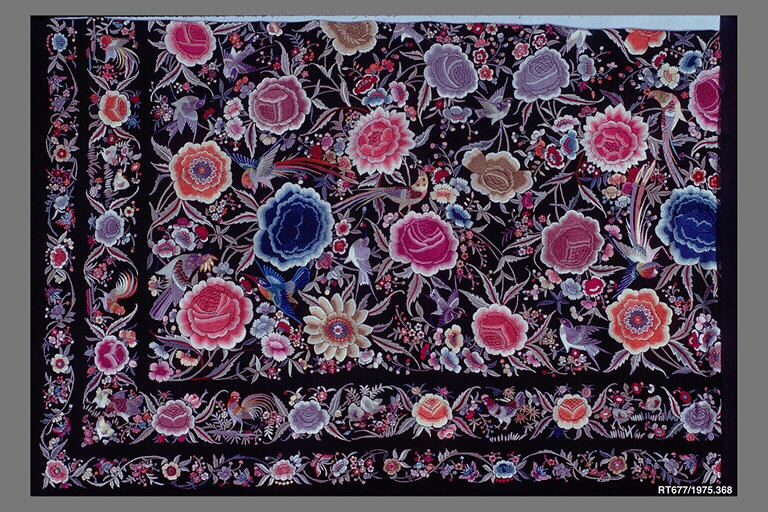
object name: shawl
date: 1876-1900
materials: silk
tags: birds,roosters,roses